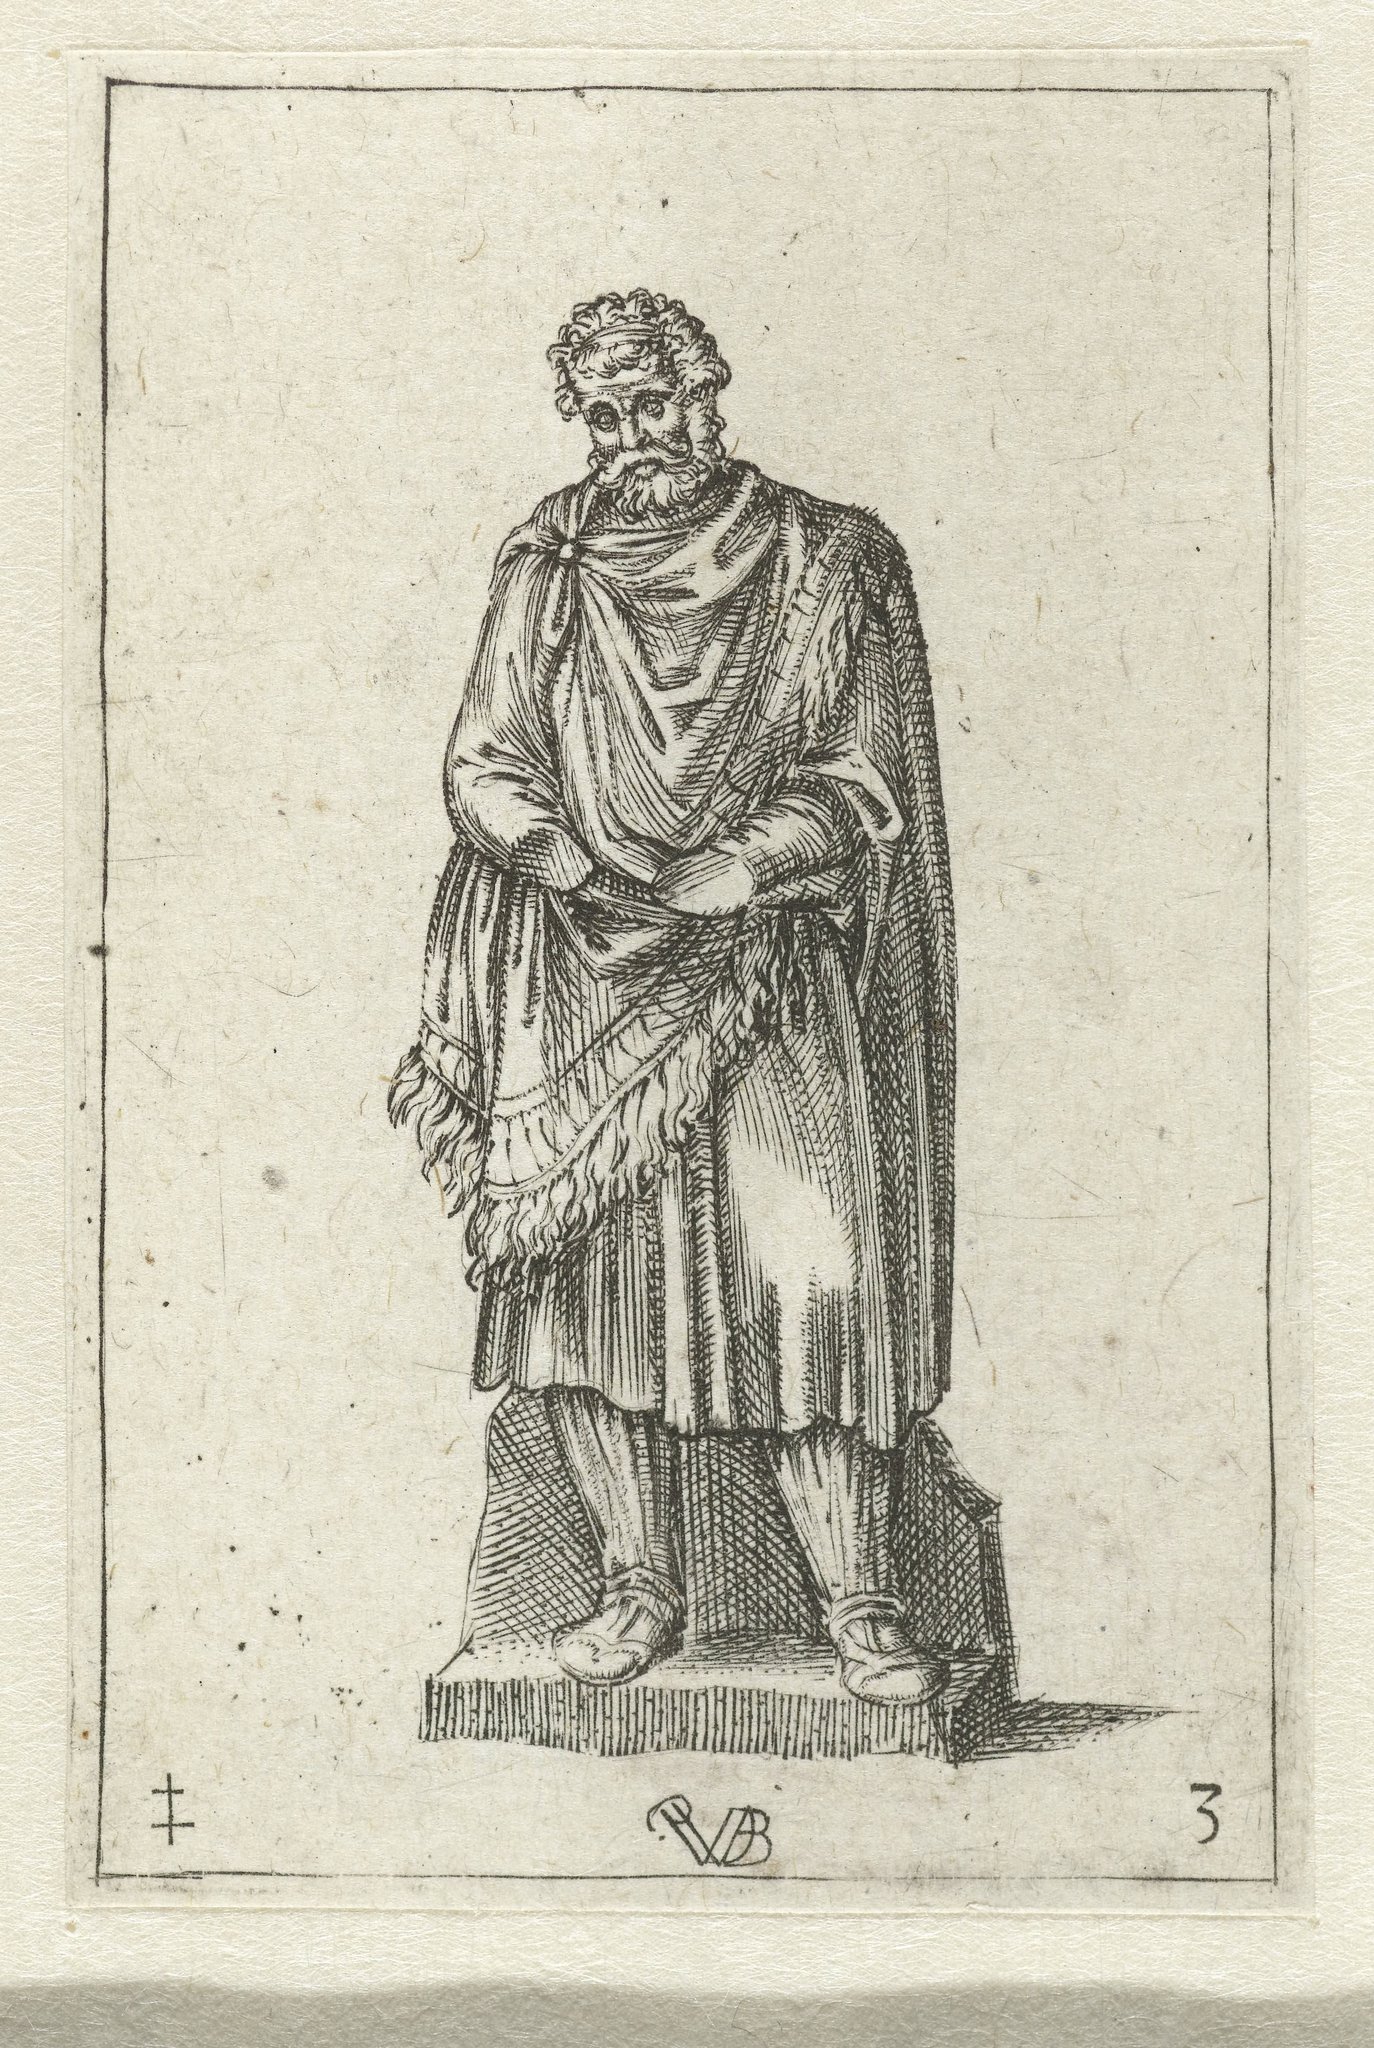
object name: print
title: Standbeeld van een staande man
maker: pierre woeiriot (ii)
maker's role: draughtsman, print maker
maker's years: 1532-1596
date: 1542-1596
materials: paper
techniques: engraving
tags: piece of sculpture, reproduction of a piece of sculpture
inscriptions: collector's mark: Lugt 240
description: Antiek standbeeld van een man, zonder handen. Mogelijk een standbeeld van een koning van de Parthen. Derde prent uit een serie van 51 met Antieke standbeelden, gevonden in Rome.